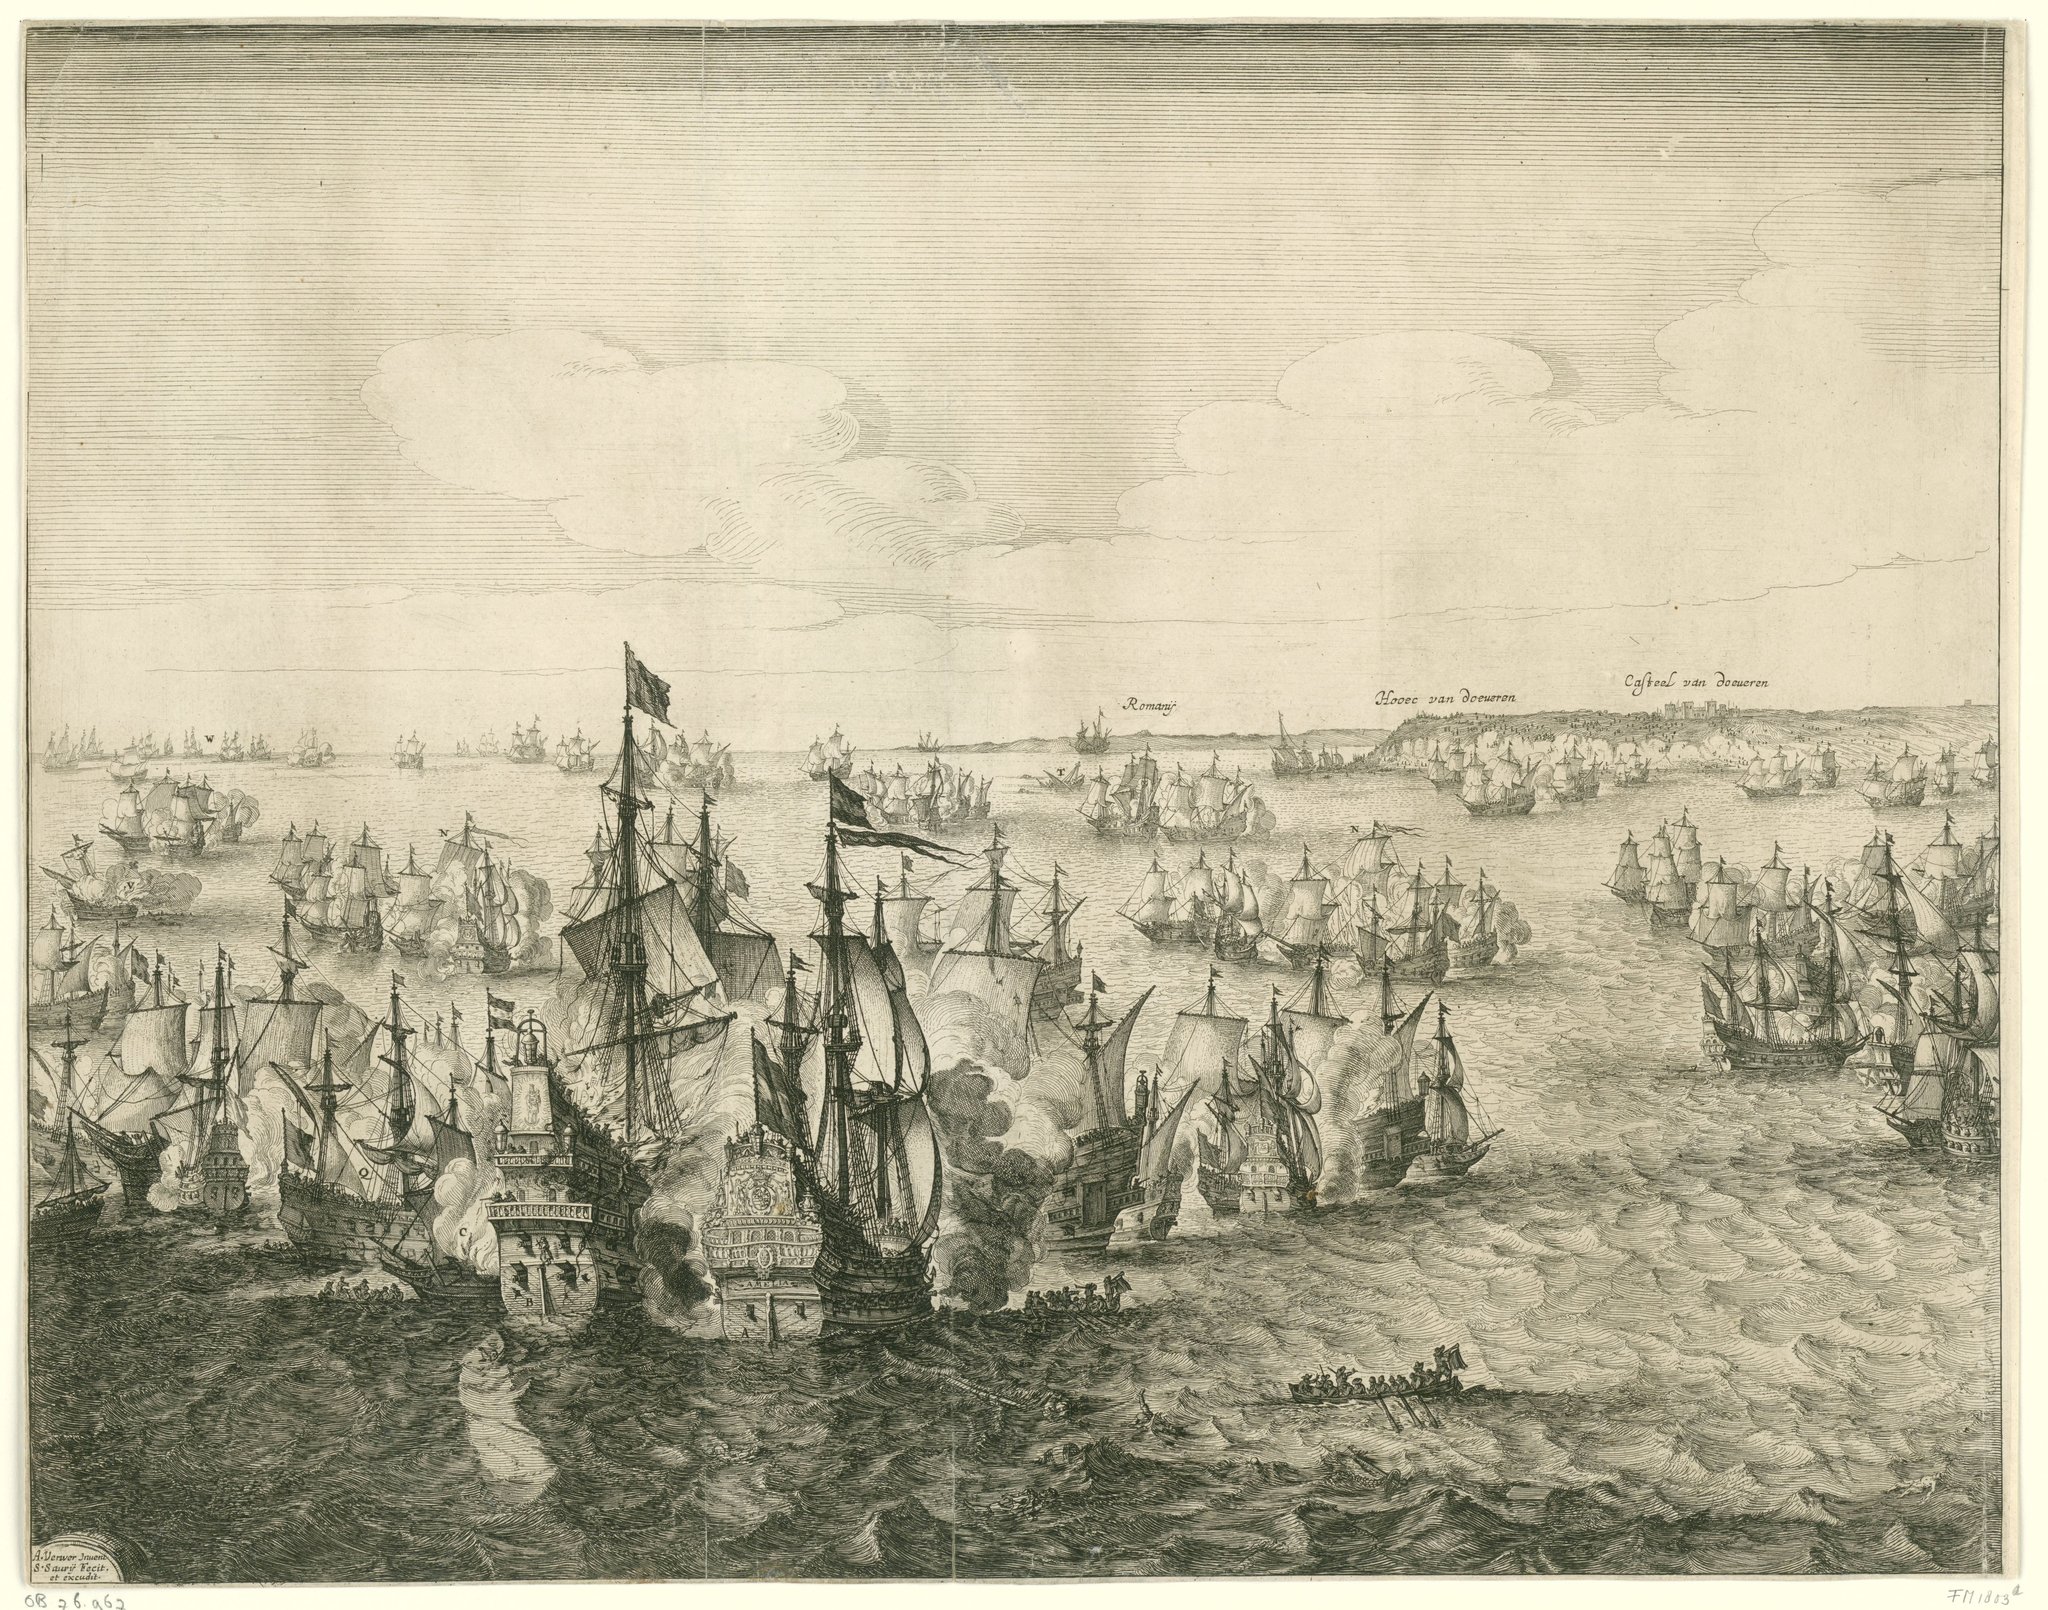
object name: print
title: Zeeslag bij Duins (linkerplaat), 1639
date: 1640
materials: paper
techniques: etching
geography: amsterdam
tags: brielle, maarten harpertszoon tromp, battle (+ naval force), battle of the downs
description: Zeeslag bij Duins tussen de Spaanse vloot onder bevel van Antonio de Oquendo en de Staatse vloot onder Maarten Harpertsz. Tromp, 21 oktober 1639. Op de voorgrond op de spiegel gezien het admiraalsschip van Tromp de Aemilia (Amelia) naast de Santa Teresa die in brand staat. Op de achtergrond de Engelse kust tussen Romney en Dover. De linkerplaat in een ongemonteerd ensemble bestaande uit een grote voorstelling in twee platen en twee tekstbladen.